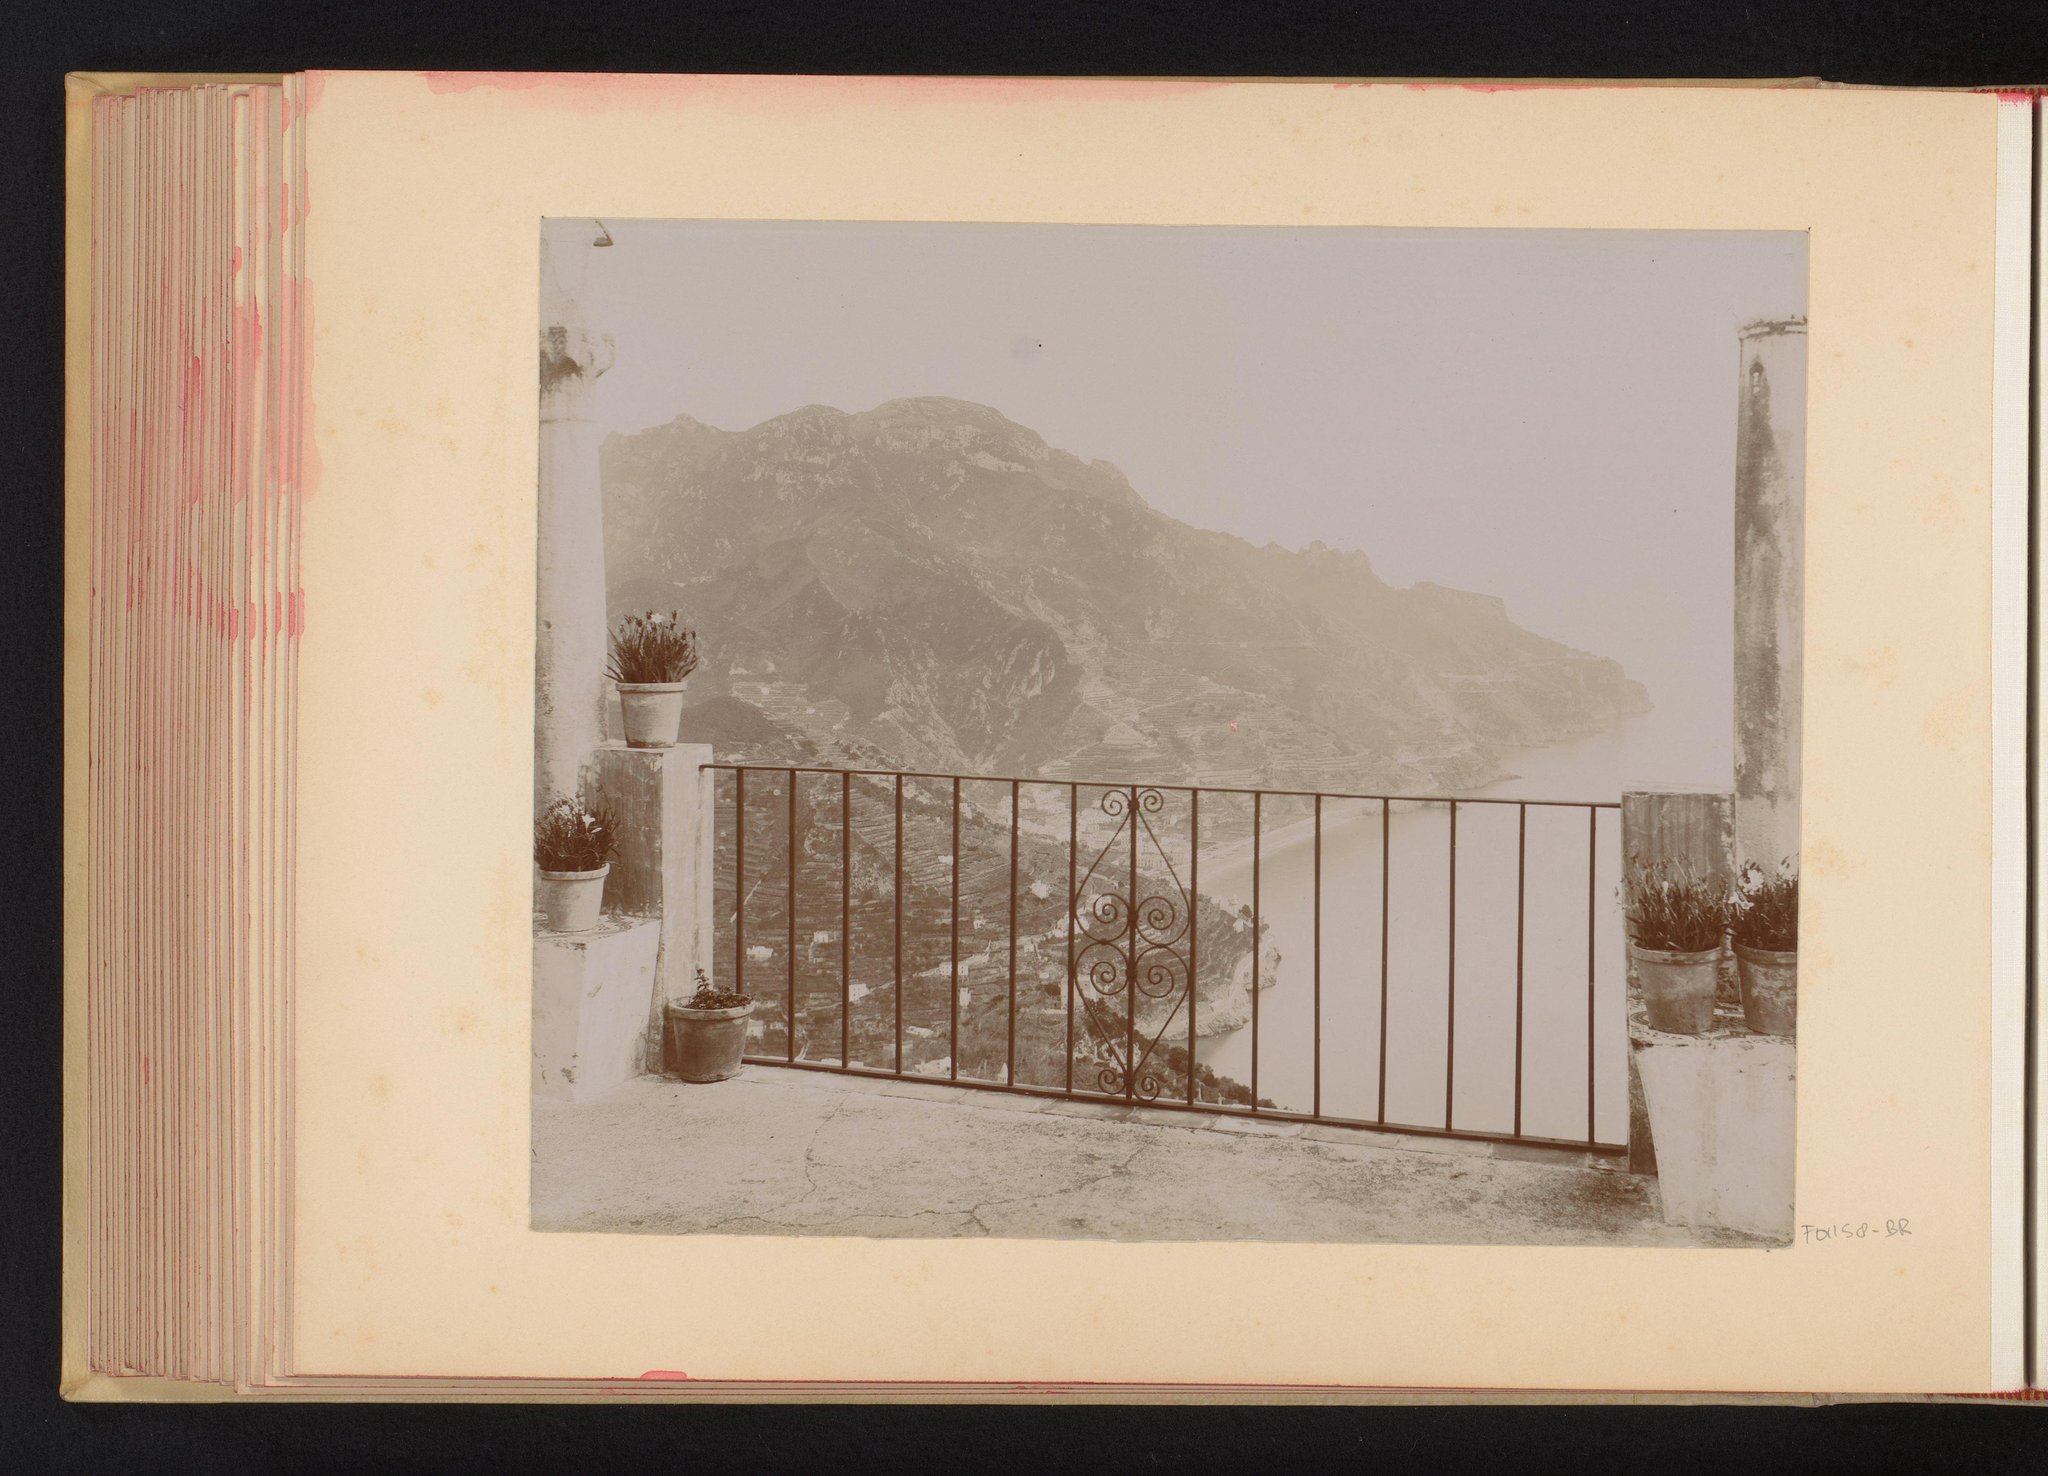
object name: photograph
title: Gezicht op een baai (vermoedelijk) te Italië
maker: Anonymous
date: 1875-1907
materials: photographic support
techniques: gelatin silver print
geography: italy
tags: gulf, bay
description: Onderdeel van Fotoalbum met opnames van bezienswaardigheden en kunstwerken in Italië.